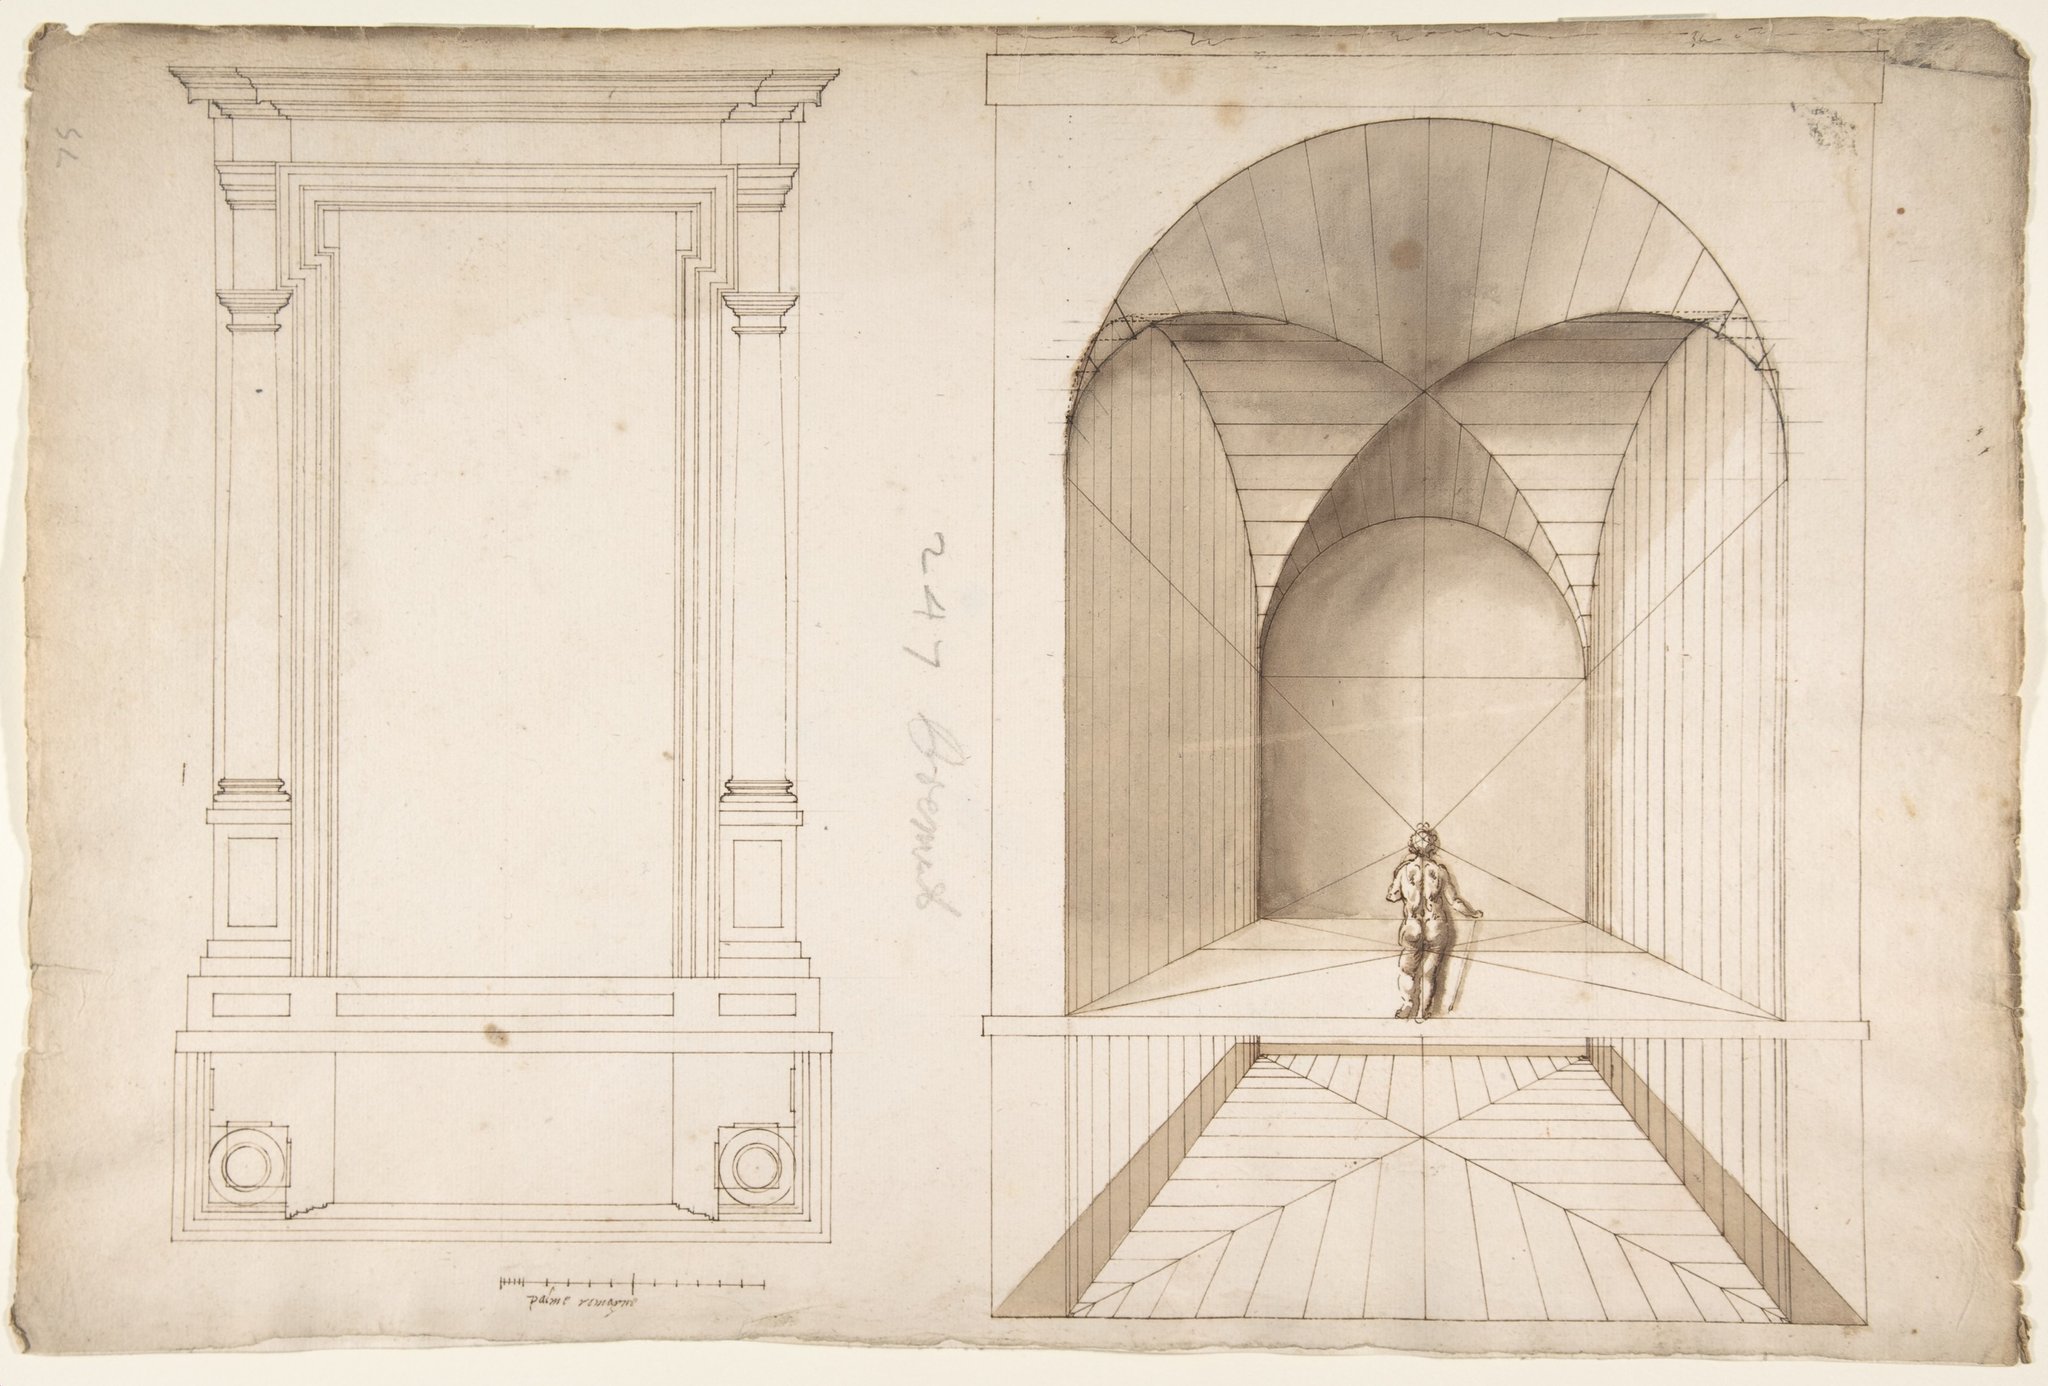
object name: drawing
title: Unknown, portal or niche, plan and elevation; perspective study, interior, square chamber with cross-vault, with a scale figure (recto); blank (verso)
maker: anonymous, french, 16th century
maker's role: draftsman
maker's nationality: french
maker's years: 1500-1600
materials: chalk, ink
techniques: incising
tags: architecture